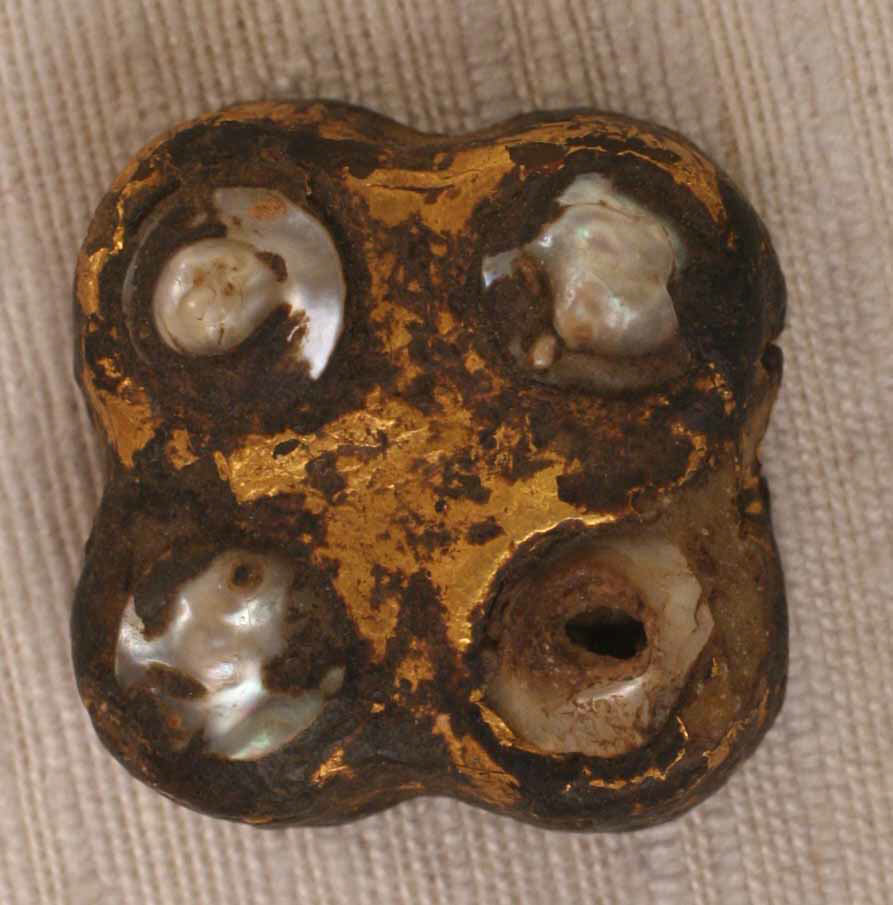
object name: plaque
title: Plaque for a Collar or Necklace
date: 701-800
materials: gold, mother of pearl, stone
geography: egypt